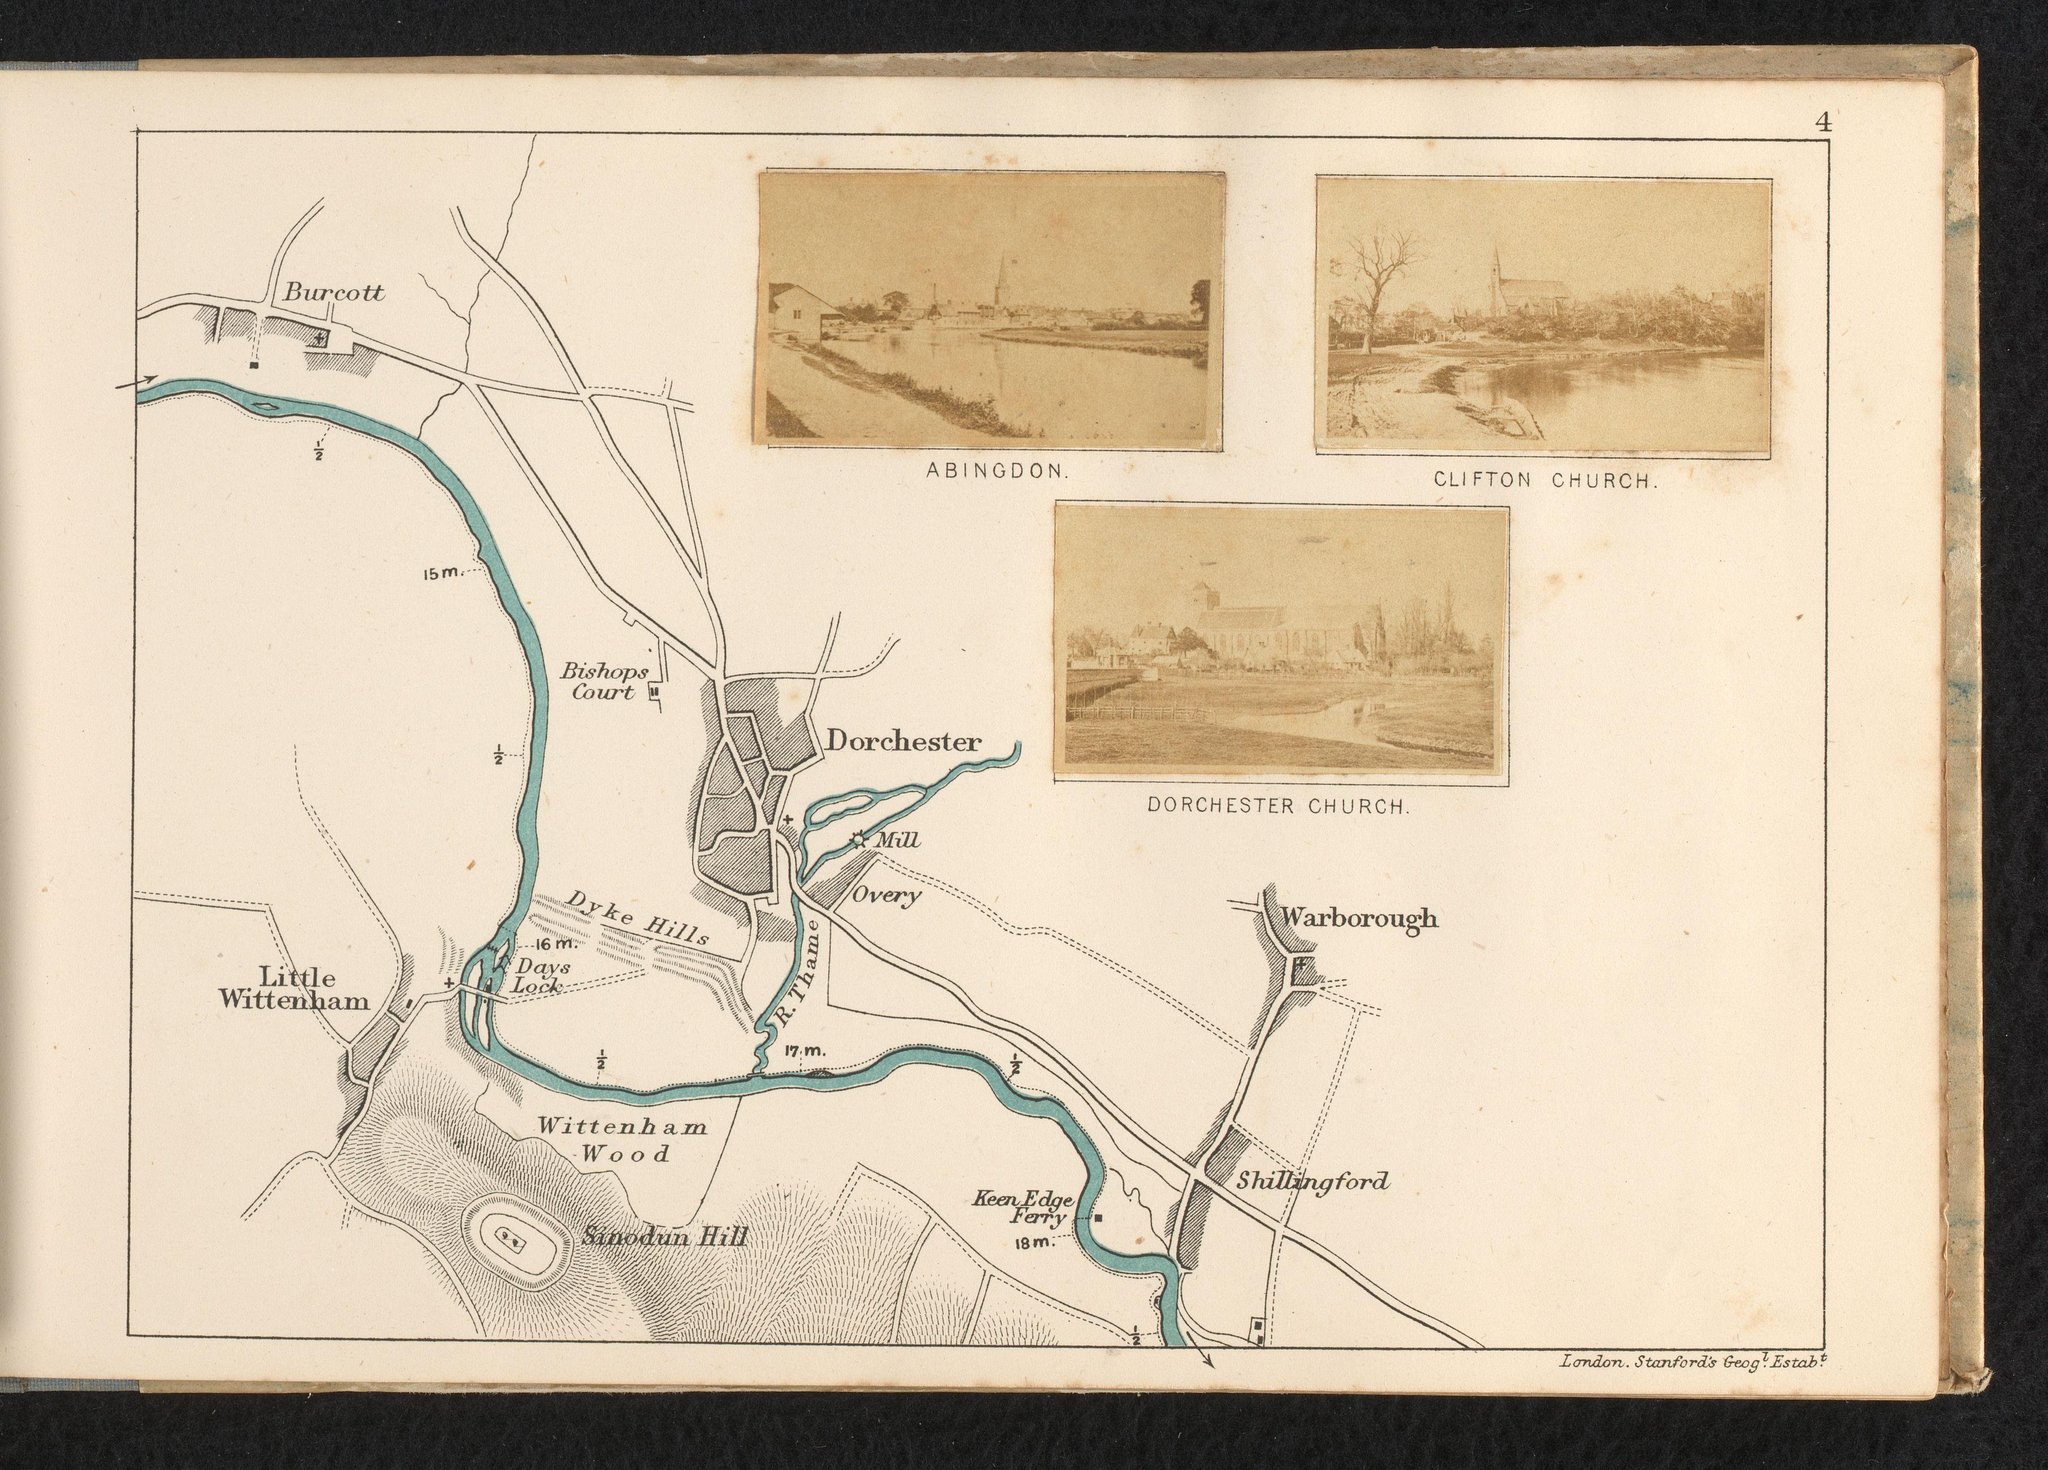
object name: photograph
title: Gezicht op oever in Abingdon, gezicht op landschap met kerk in Clifton en kerk in Dorchester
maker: Anonymous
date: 1868-1873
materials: paper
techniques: albumen print, letterpress printing, line block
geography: oxfordshire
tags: landscapes in the temperate zone, river bank, church (exterior)